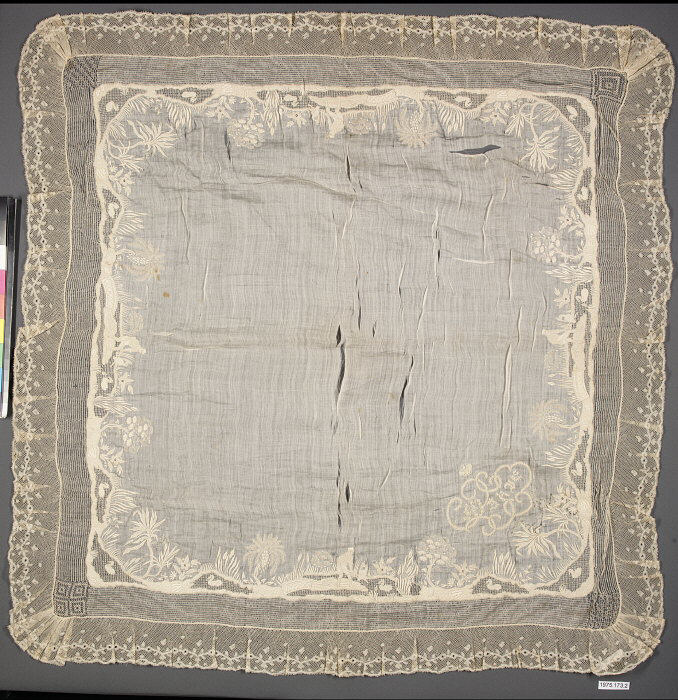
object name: handkerchief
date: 1860-1869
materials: linen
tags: plants